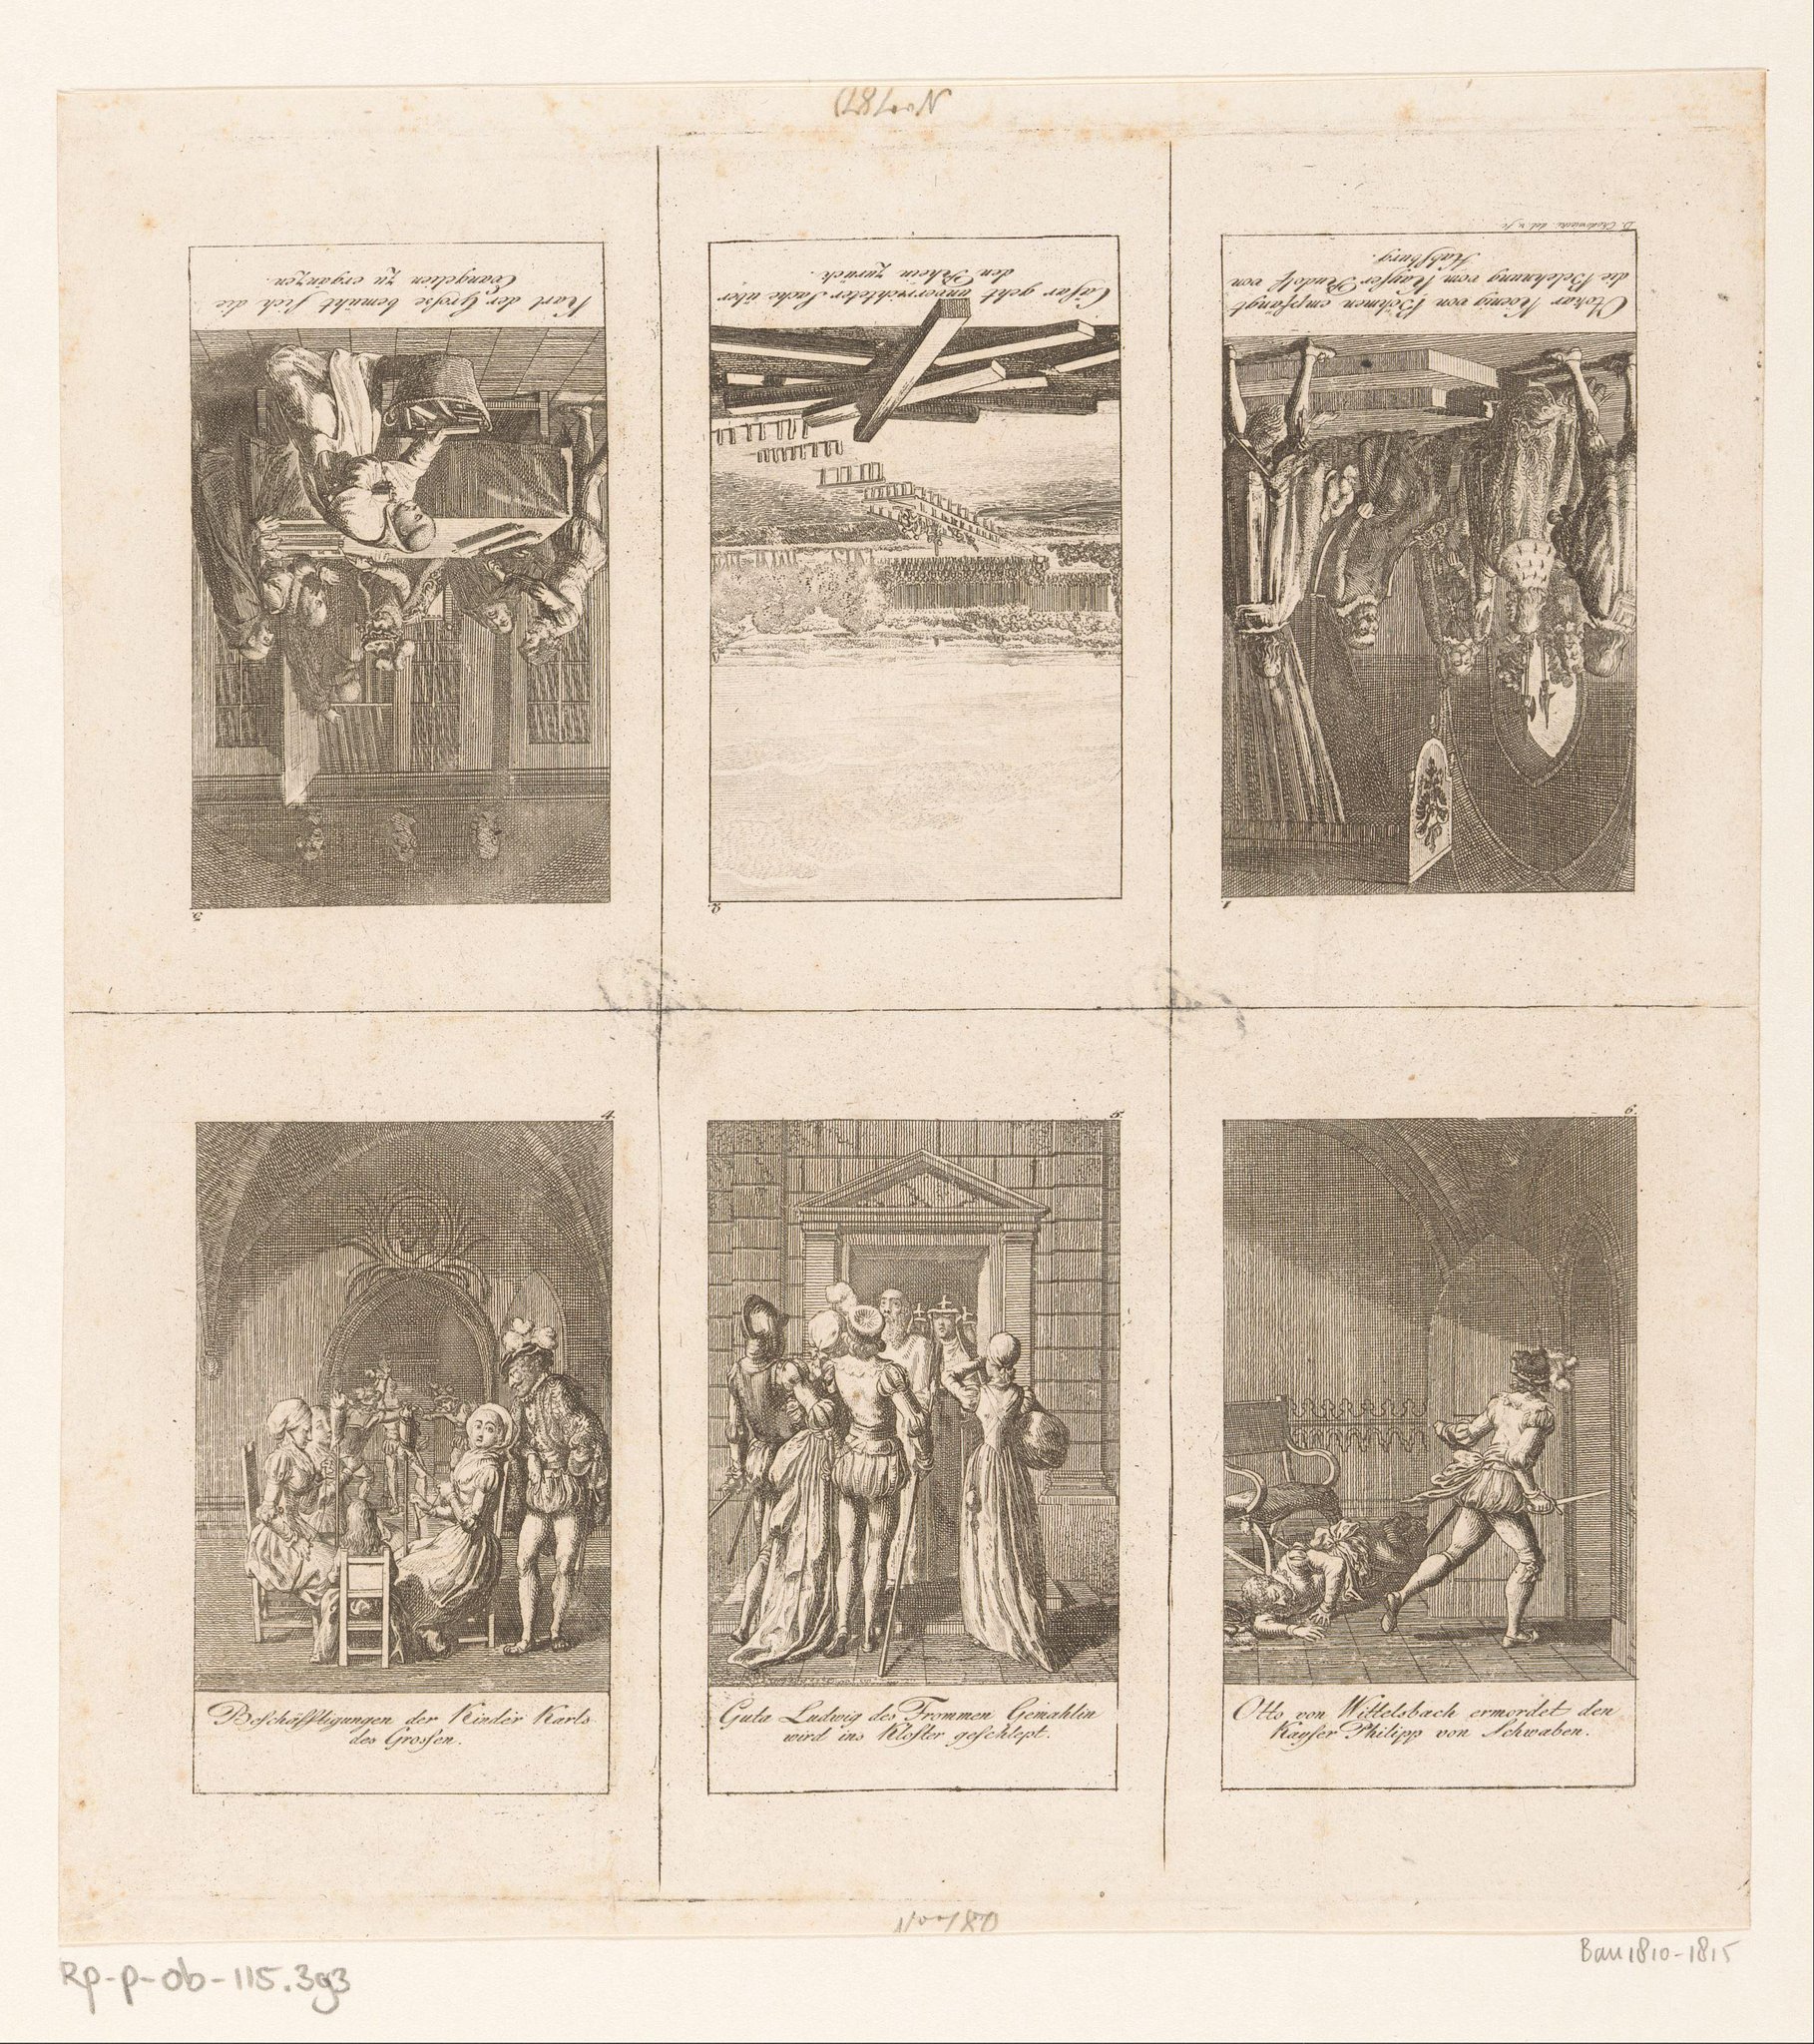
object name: print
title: Zes voorstellingen uit de oudere en middelste geschiedenis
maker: daniel nikolaus chodowiecki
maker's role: draughtsman, print maker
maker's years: 1726-1801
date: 1796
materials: paper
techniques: etching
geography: berlin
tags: earl, charlemagne (holy roman emperor), father and daughter(s) (family group), double-headed eagle, improvised bridge, temporary bridge ~ military engineering, history, nun(s), land forces, spindle, monk(s), friar(s), study; 'studiolo'; library, cloisters ~ monastery, ruler, sovereign, kneeling figure, murderer, hacking and thrusting weapons: rapier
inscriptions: collector's mark: Lugt 2228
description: Prenten gebruikt voor: Königl. Grossbritanischer Historischer Genealogischer Calender für 1796 (...). Lauenburg en Franfurt am Main: Johann Georg Berenberg en Jaegerschen Buchhandlung, [1795].